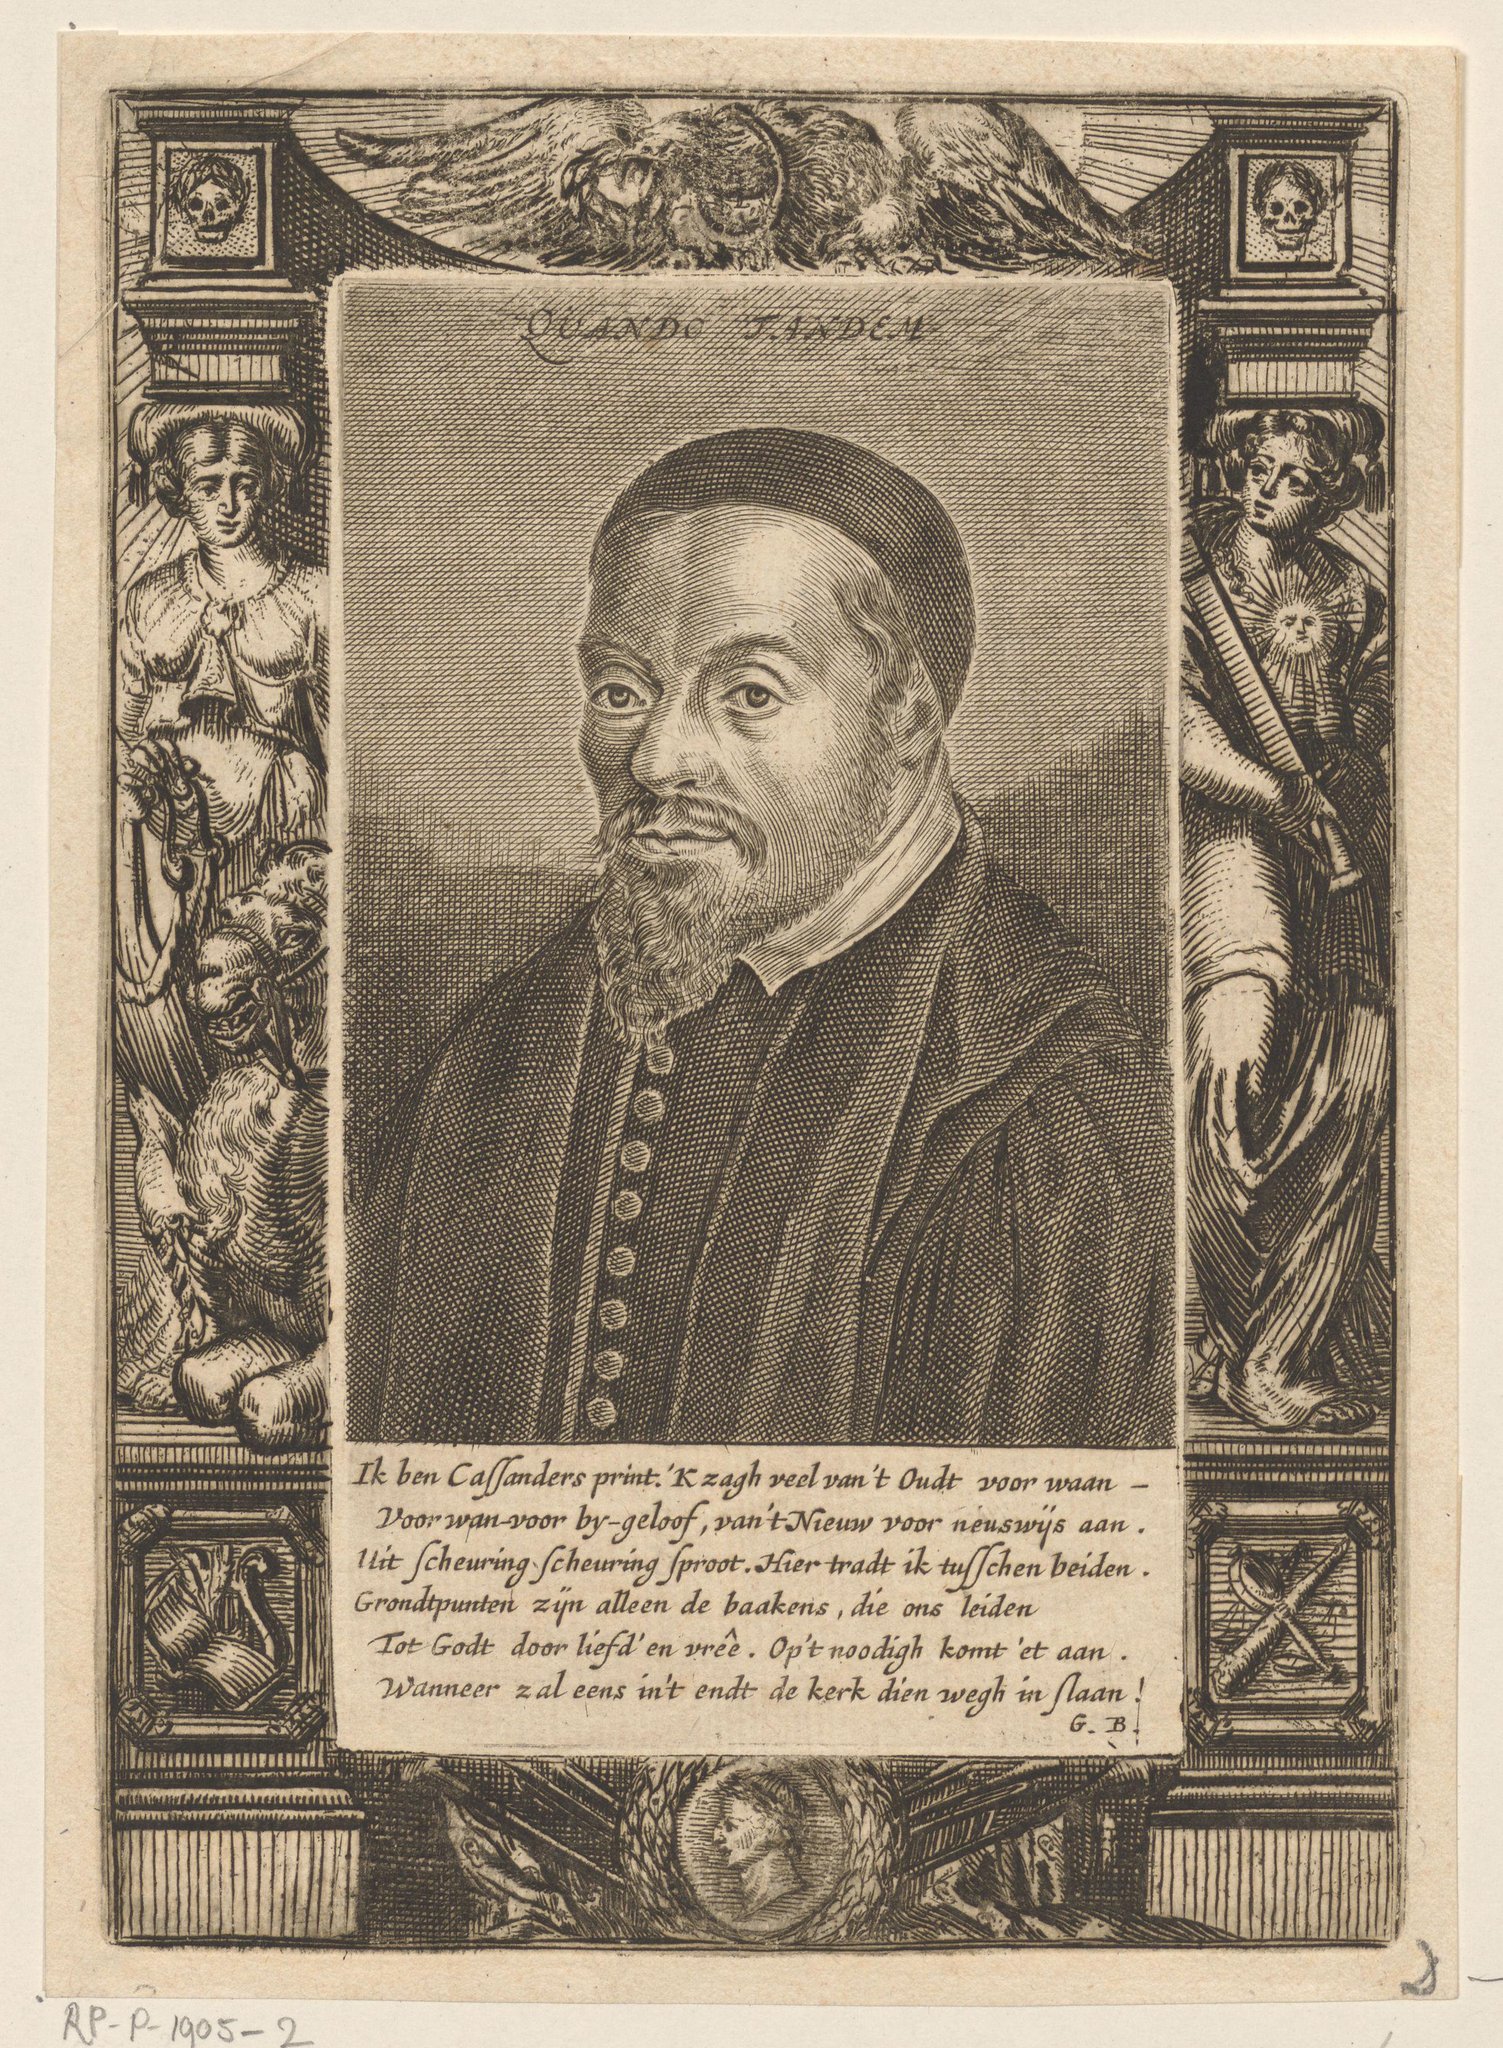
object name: print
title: Portret van Joris Cassander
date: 1671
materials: paper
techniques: engraving, etching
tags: bruges, cologne, historical persons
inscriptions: collector's mark: Lugt 2228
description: Prent mogelijk uit: Geeraert Brandt I. Historie der Reformatie. Amsterdam: Rieuwertsz. I, en Hendrick en Dirk Boom, 1671, dl. 1.